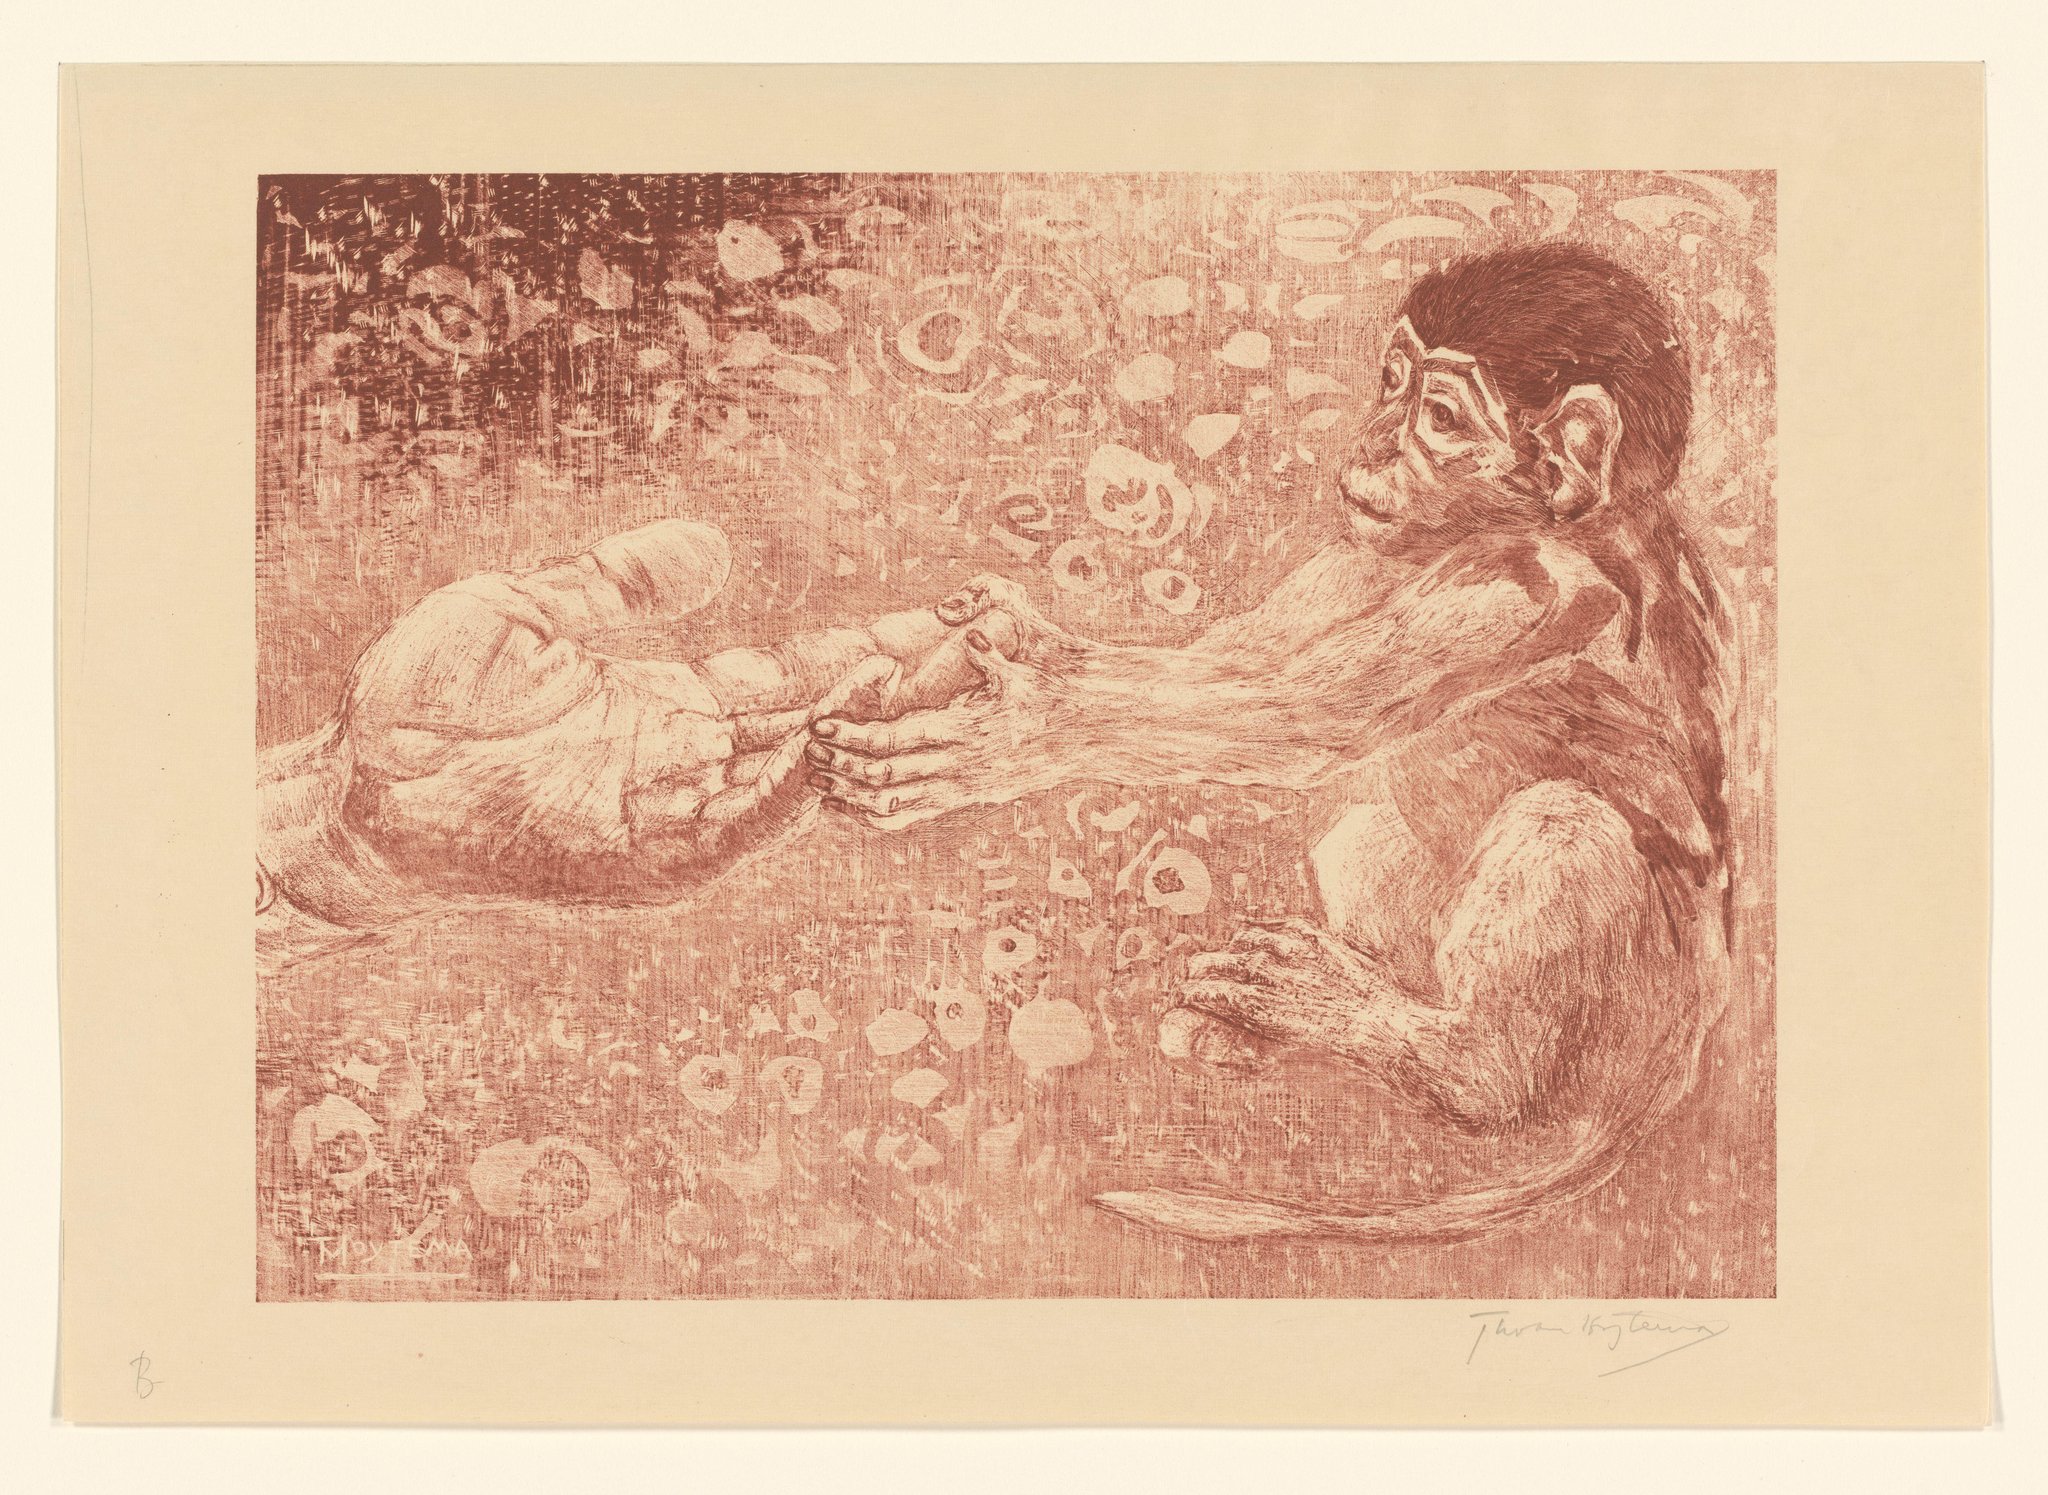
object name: print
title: Aap die een toegestoken hand pakt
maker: theo van hoytema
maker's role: draughtsman, painter, print maker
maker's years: 1863-1917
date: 1878-1914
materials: paper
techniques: lithograph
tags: monkeys, apes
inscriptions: collector's mark: Lugt 2233